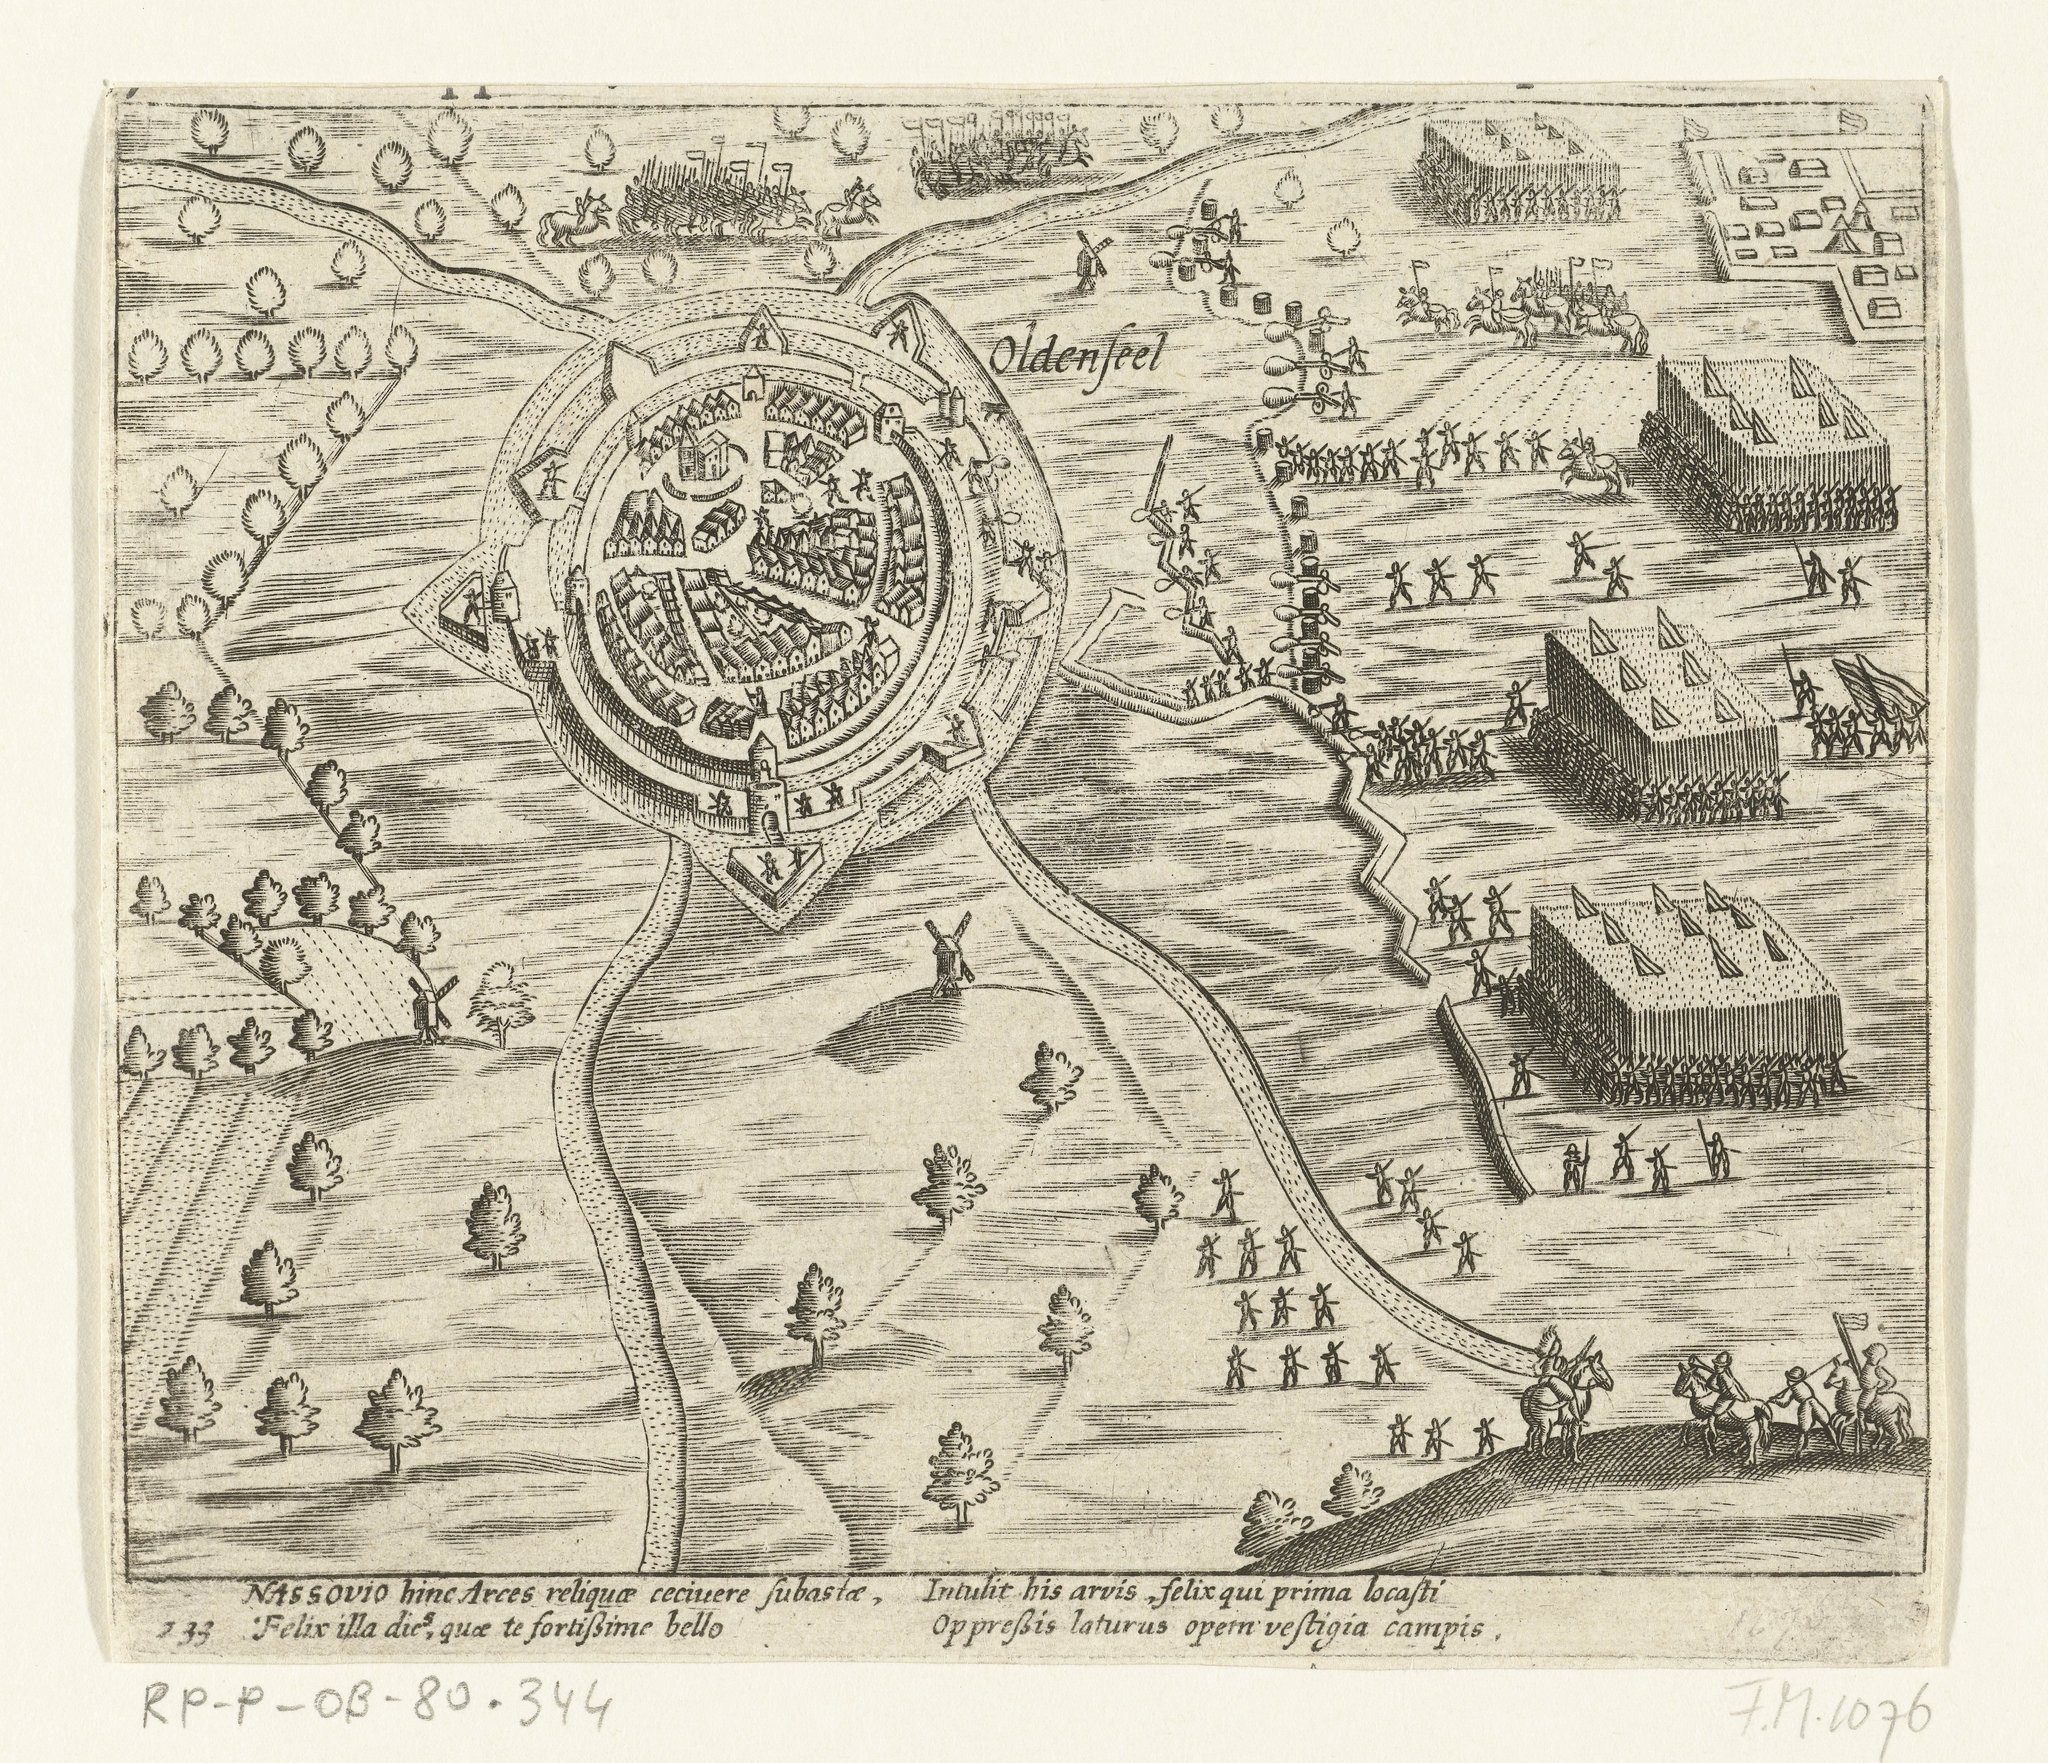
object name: print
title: Verovering van Oldenzaal, 1597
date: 1613-1615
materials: paper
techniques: engraving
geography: northern netherlands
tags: the hague, maurice (prince of orange), siege, position war, capture of city (after the siege)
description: Verovering van Oldenzaal door het Staatse leger onder prins Maurits, 22 oktober 1597. Plan van de stad en omgeving met de posities van het Staatse leger. Met onderschrift van vier regels in het Latijn. Genummerd 233. Bedrukt op de achterzijde met tekst in het Latijn.